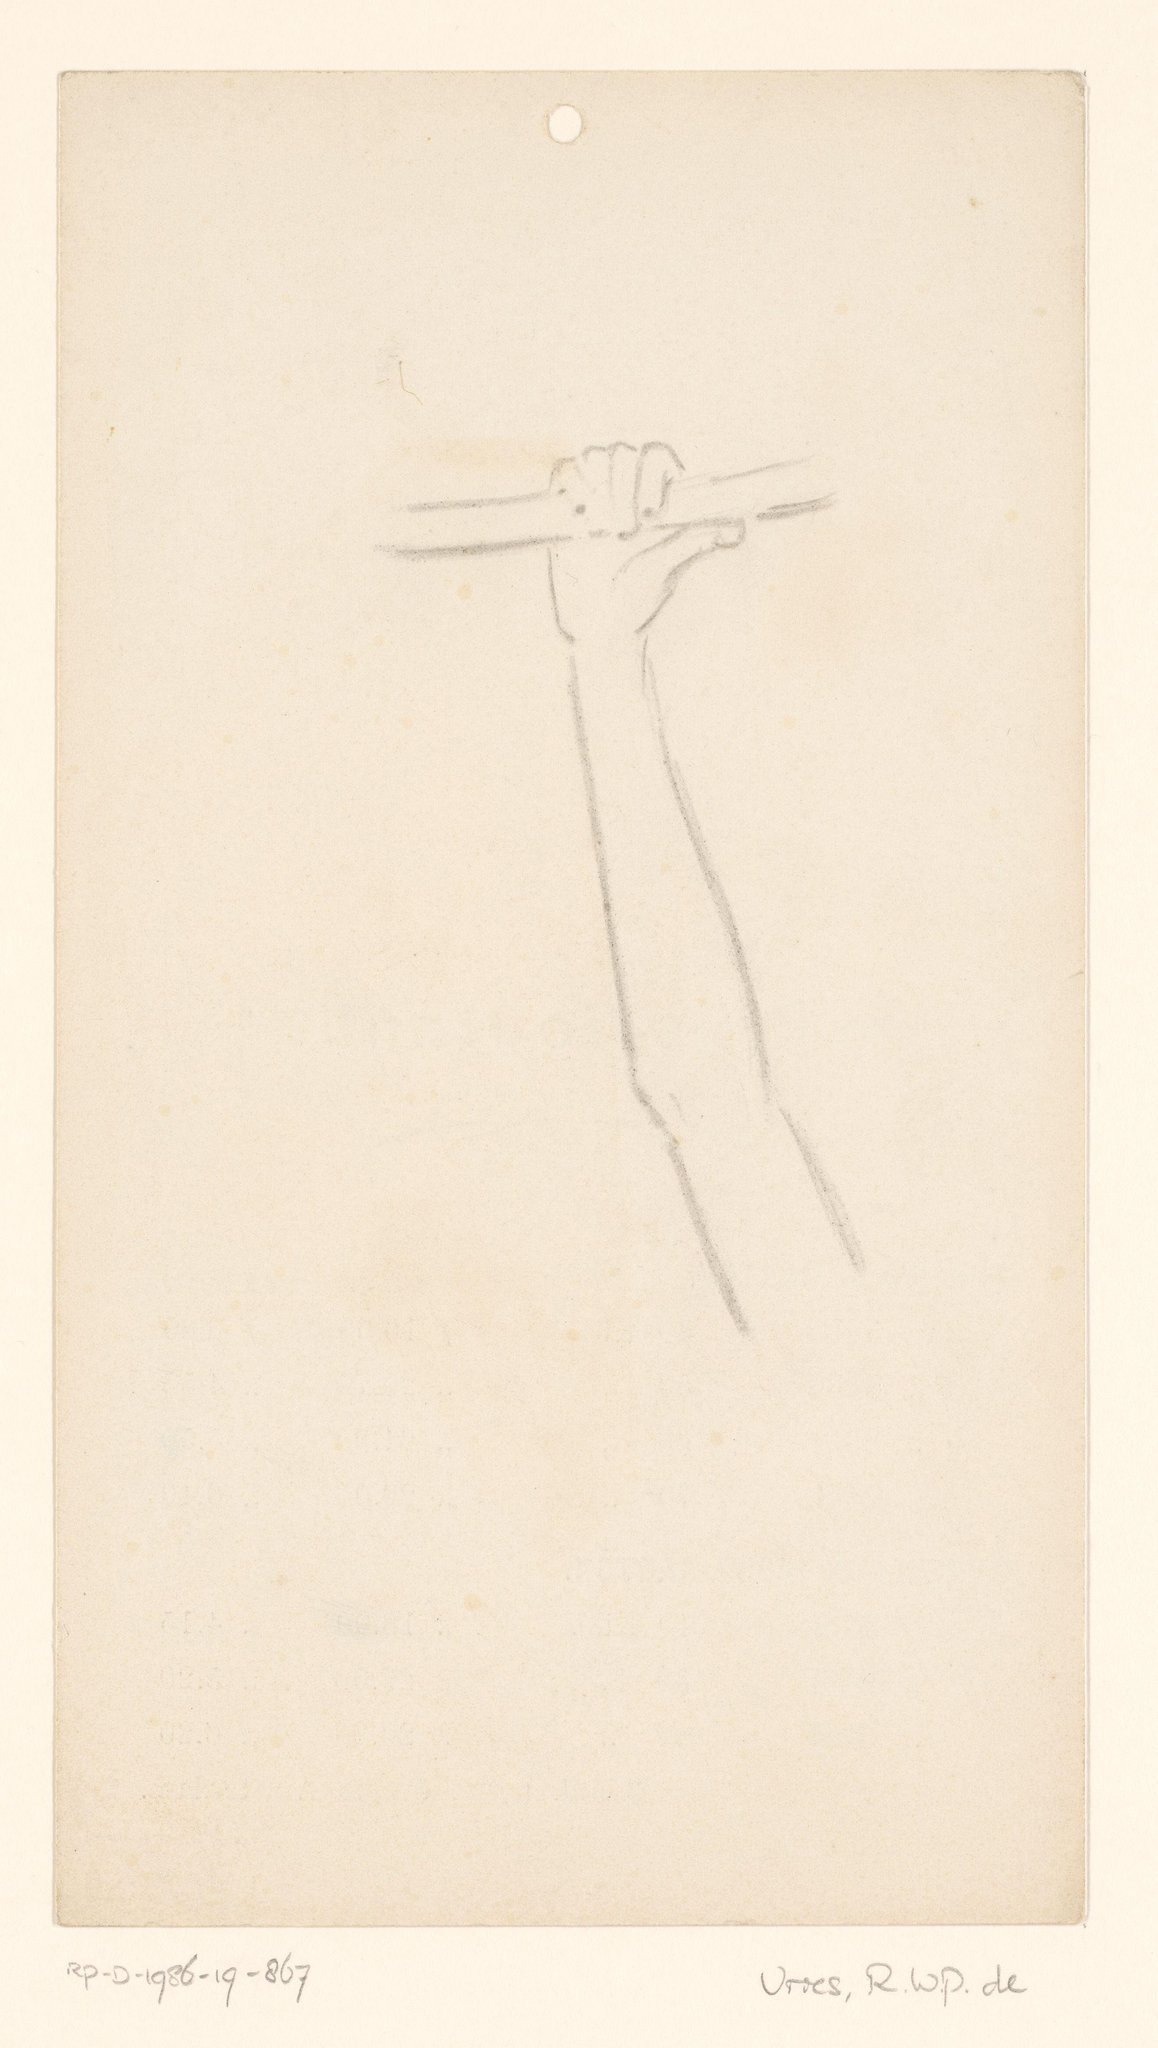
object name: drawing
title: Hand die een voorwerp vasthoudt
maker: reinier willem petrus de vries (1874-1953)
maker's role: draughtsman, print maker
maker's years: 1874-1953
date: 1884-1952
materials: chalk, paper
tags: postures and gestures of arms and hands in general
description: Hand die een langwerpig voorwerp, mogelijk een stok of paal, vasthoudt.